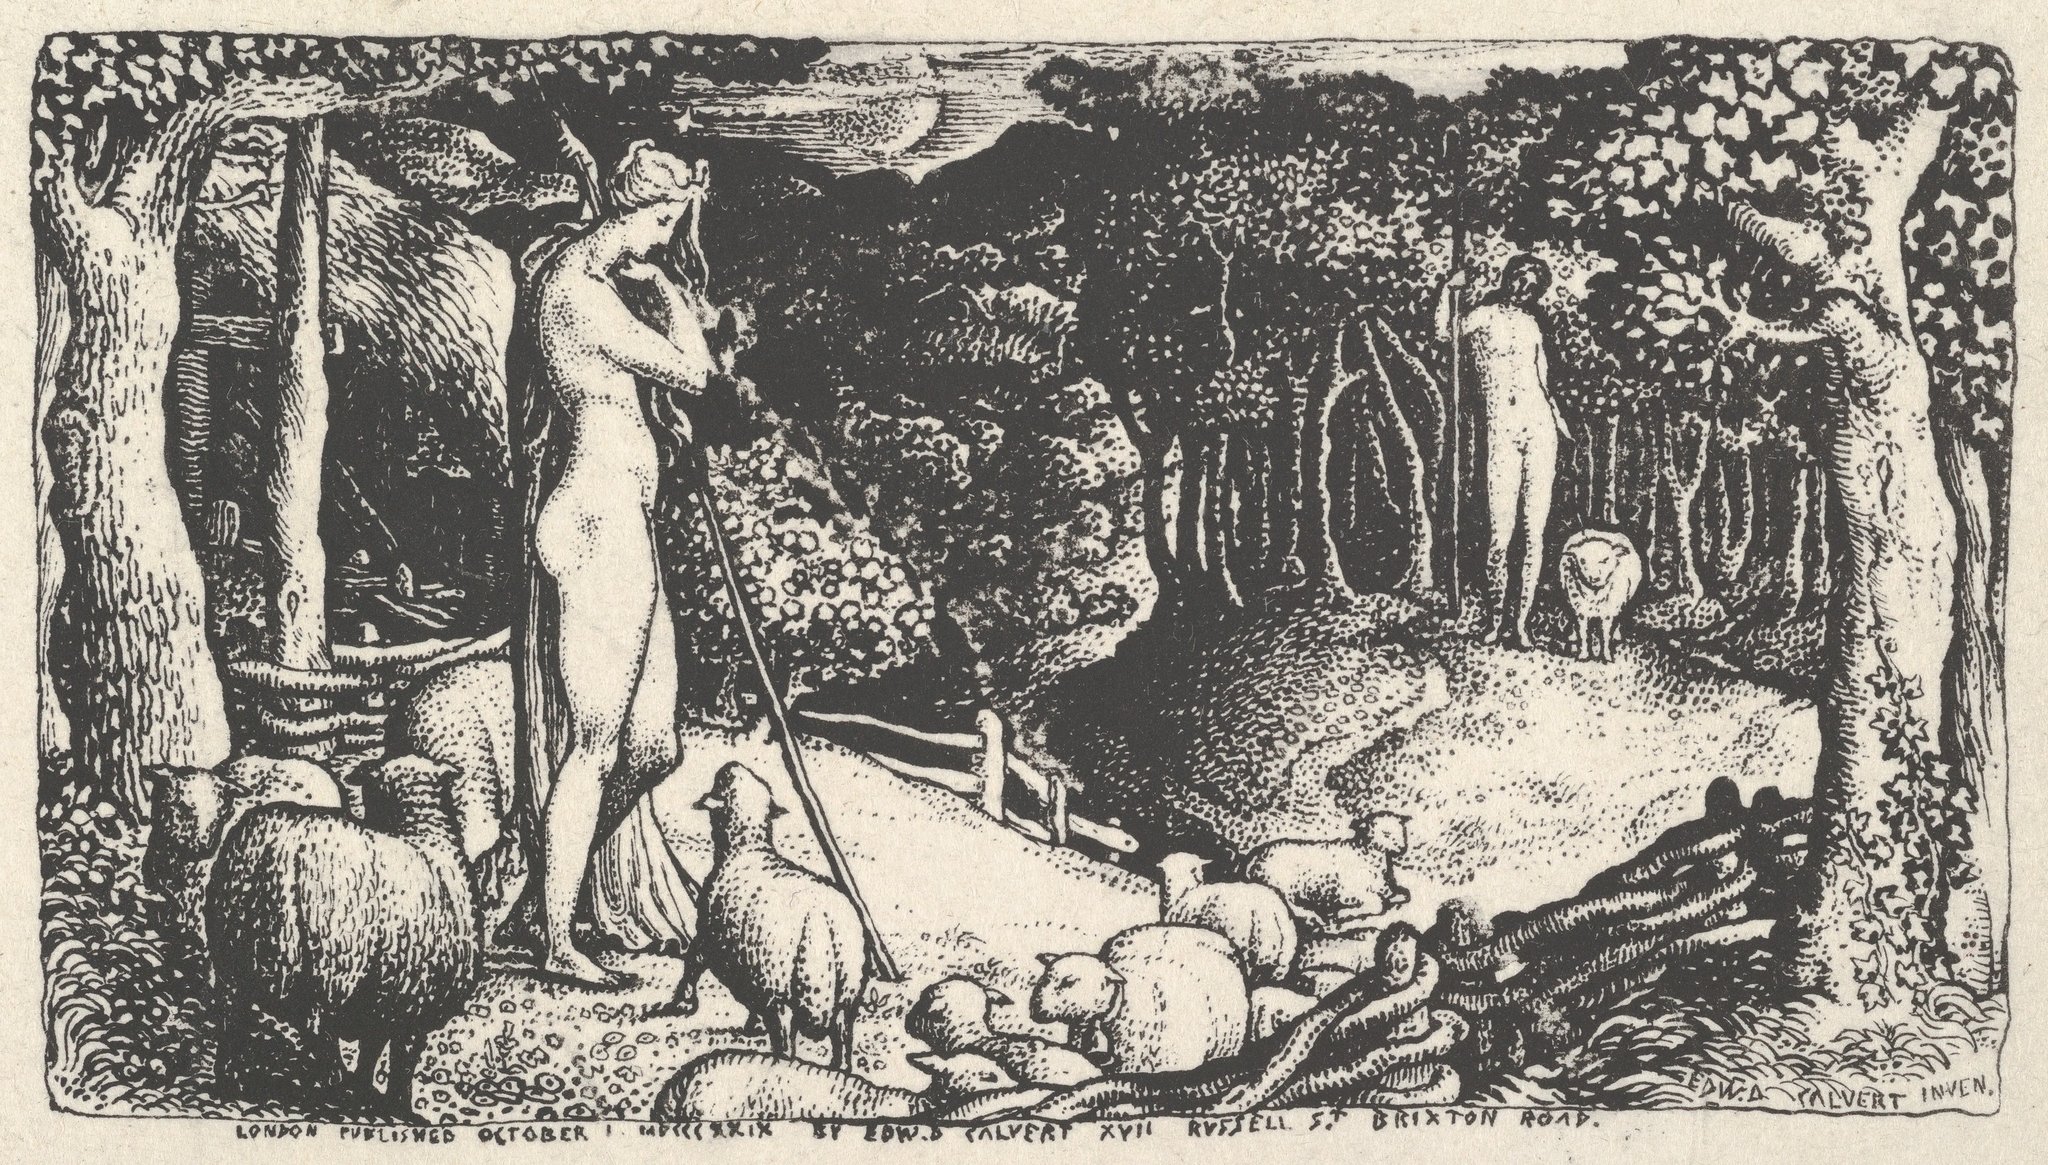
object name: print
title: Ideal Pastoral Life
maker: edward calvert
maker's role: artist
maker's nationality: british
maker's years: 1799-1883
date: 1829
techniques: lithograph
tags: animals,female nudes,trees